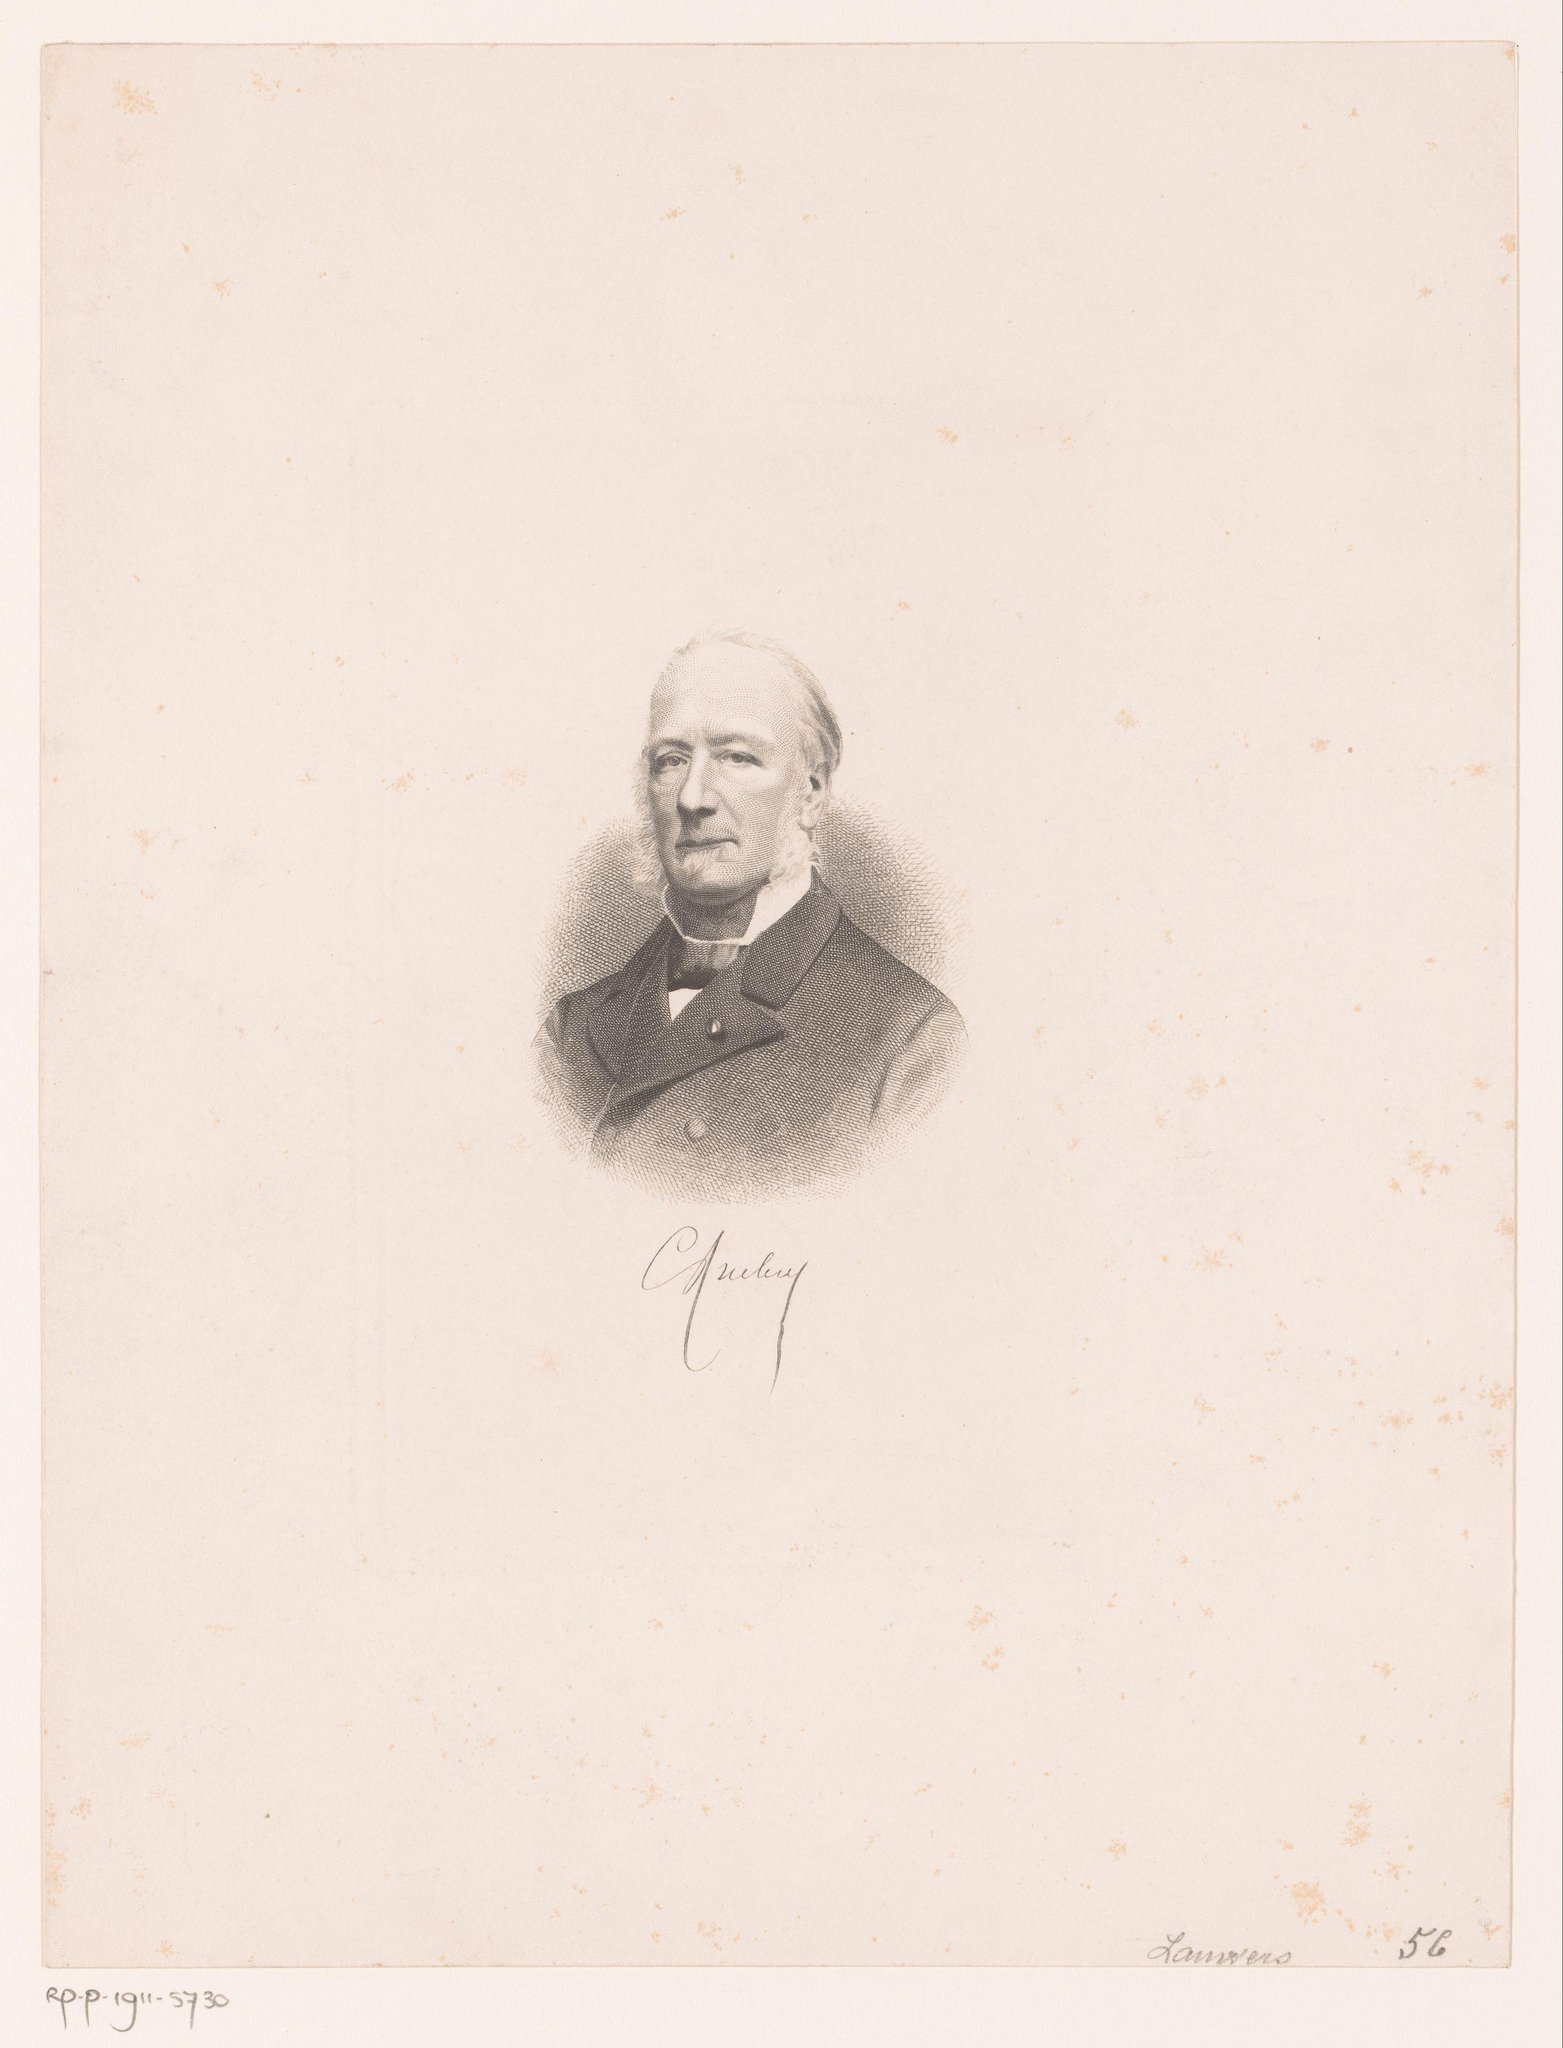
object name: print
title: C. Ruelens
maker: frans lauwers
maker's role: print maker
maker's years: 1854-1931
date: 1864-1911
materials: paper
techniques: etching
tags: historical persons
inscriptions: collector's mark: Lugt 2228